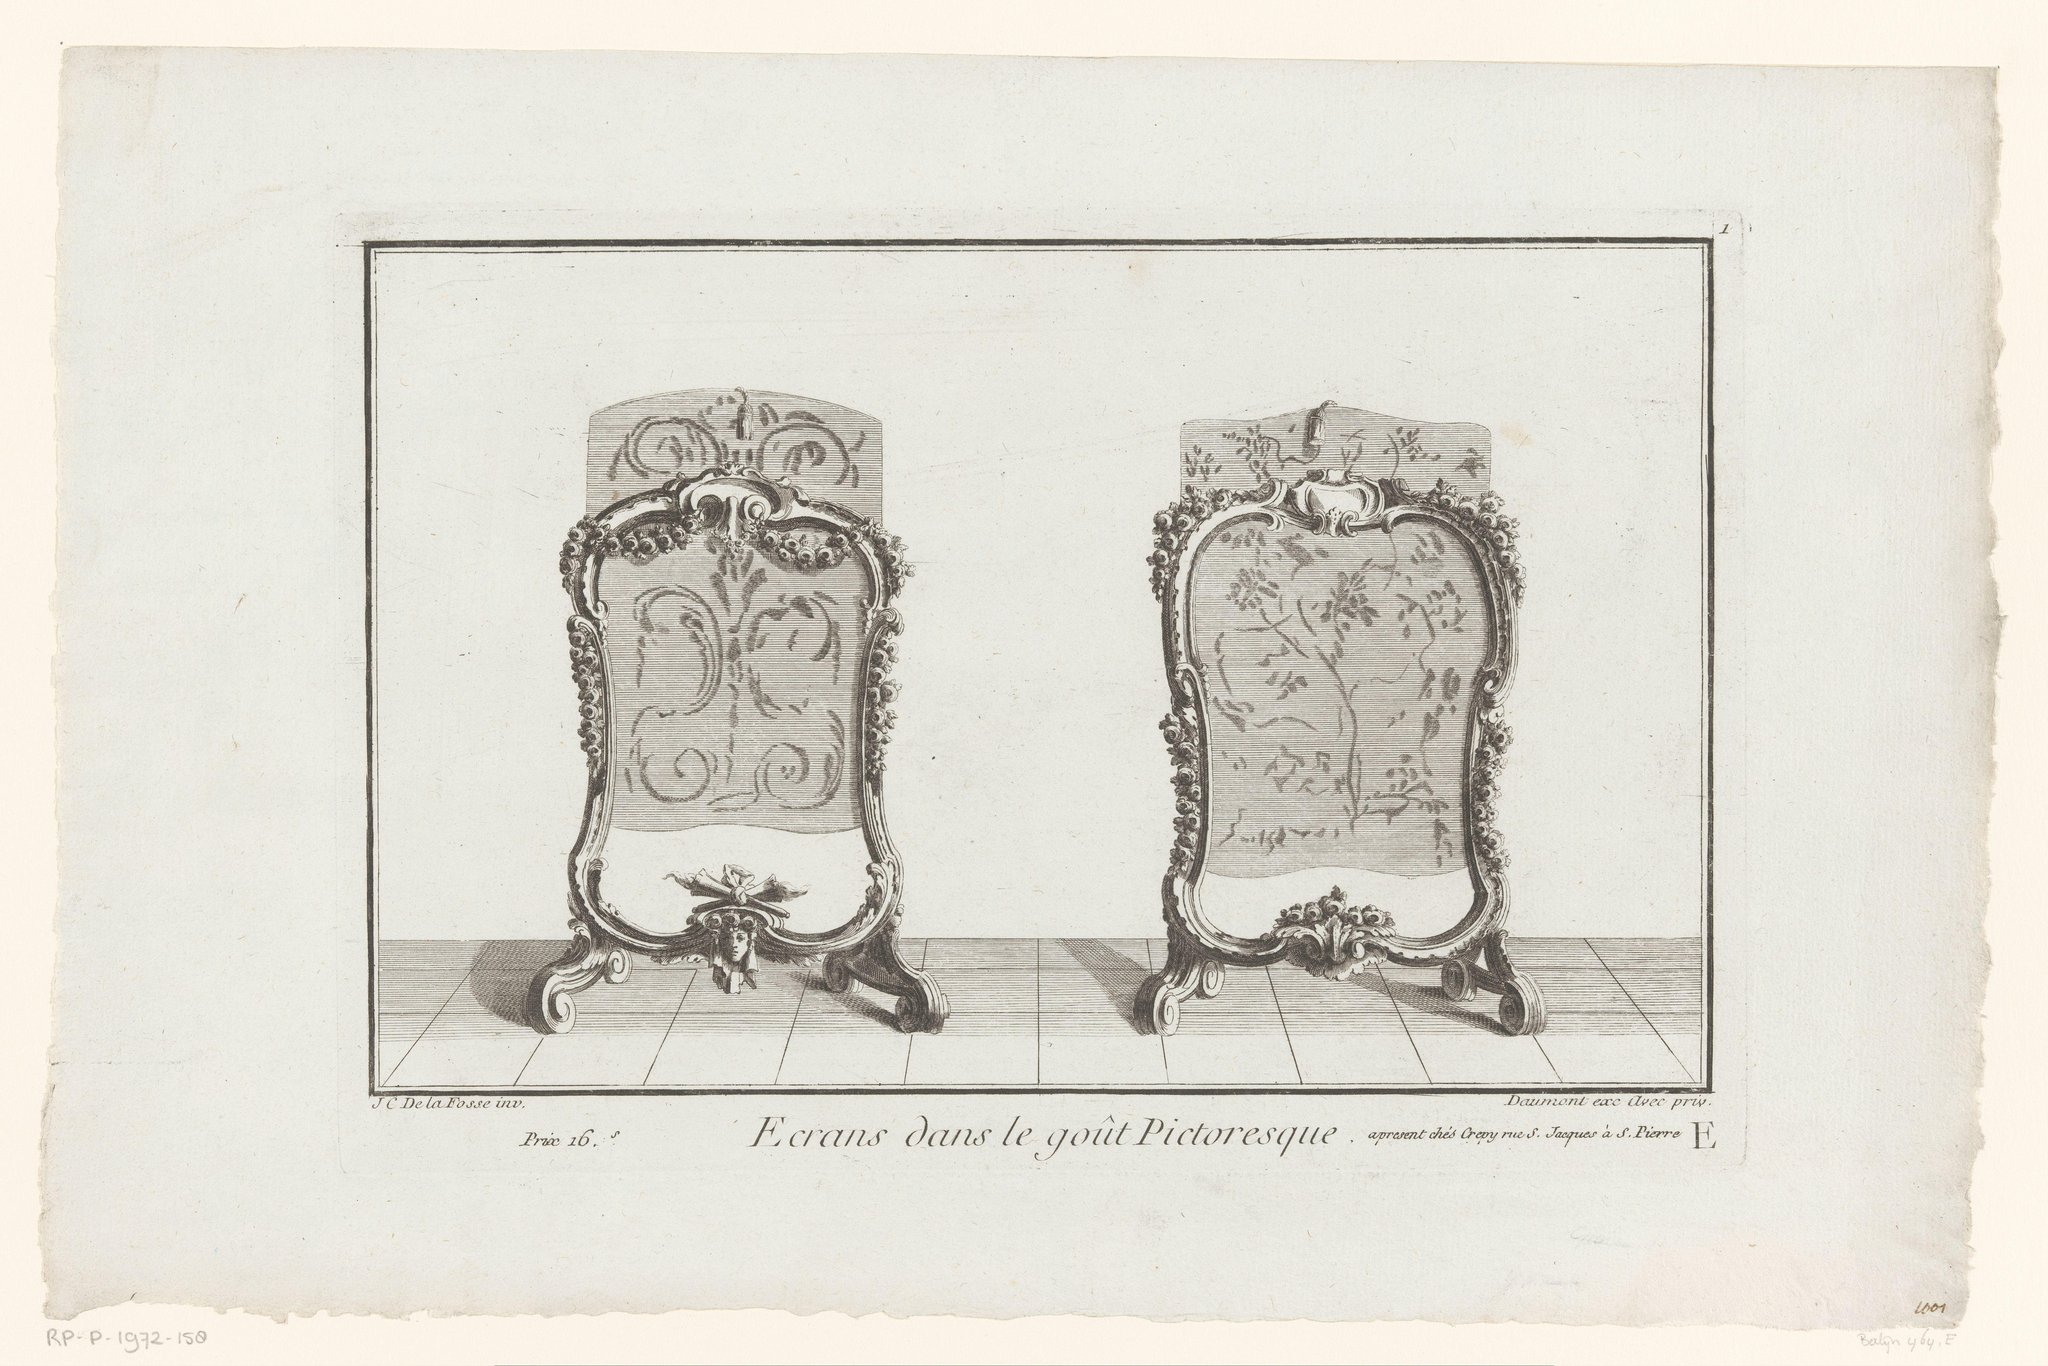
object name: print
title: Ecrans dans le goût Pictoresque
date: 1753-1775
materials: paper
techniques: engraving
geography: paris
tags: fire-screen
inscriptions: collector's mark: Lugt 2228, collector's mark: Lugt 2760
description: Twee haardschermen met schelpmotieven, guirlandes, een masker en fakkels.